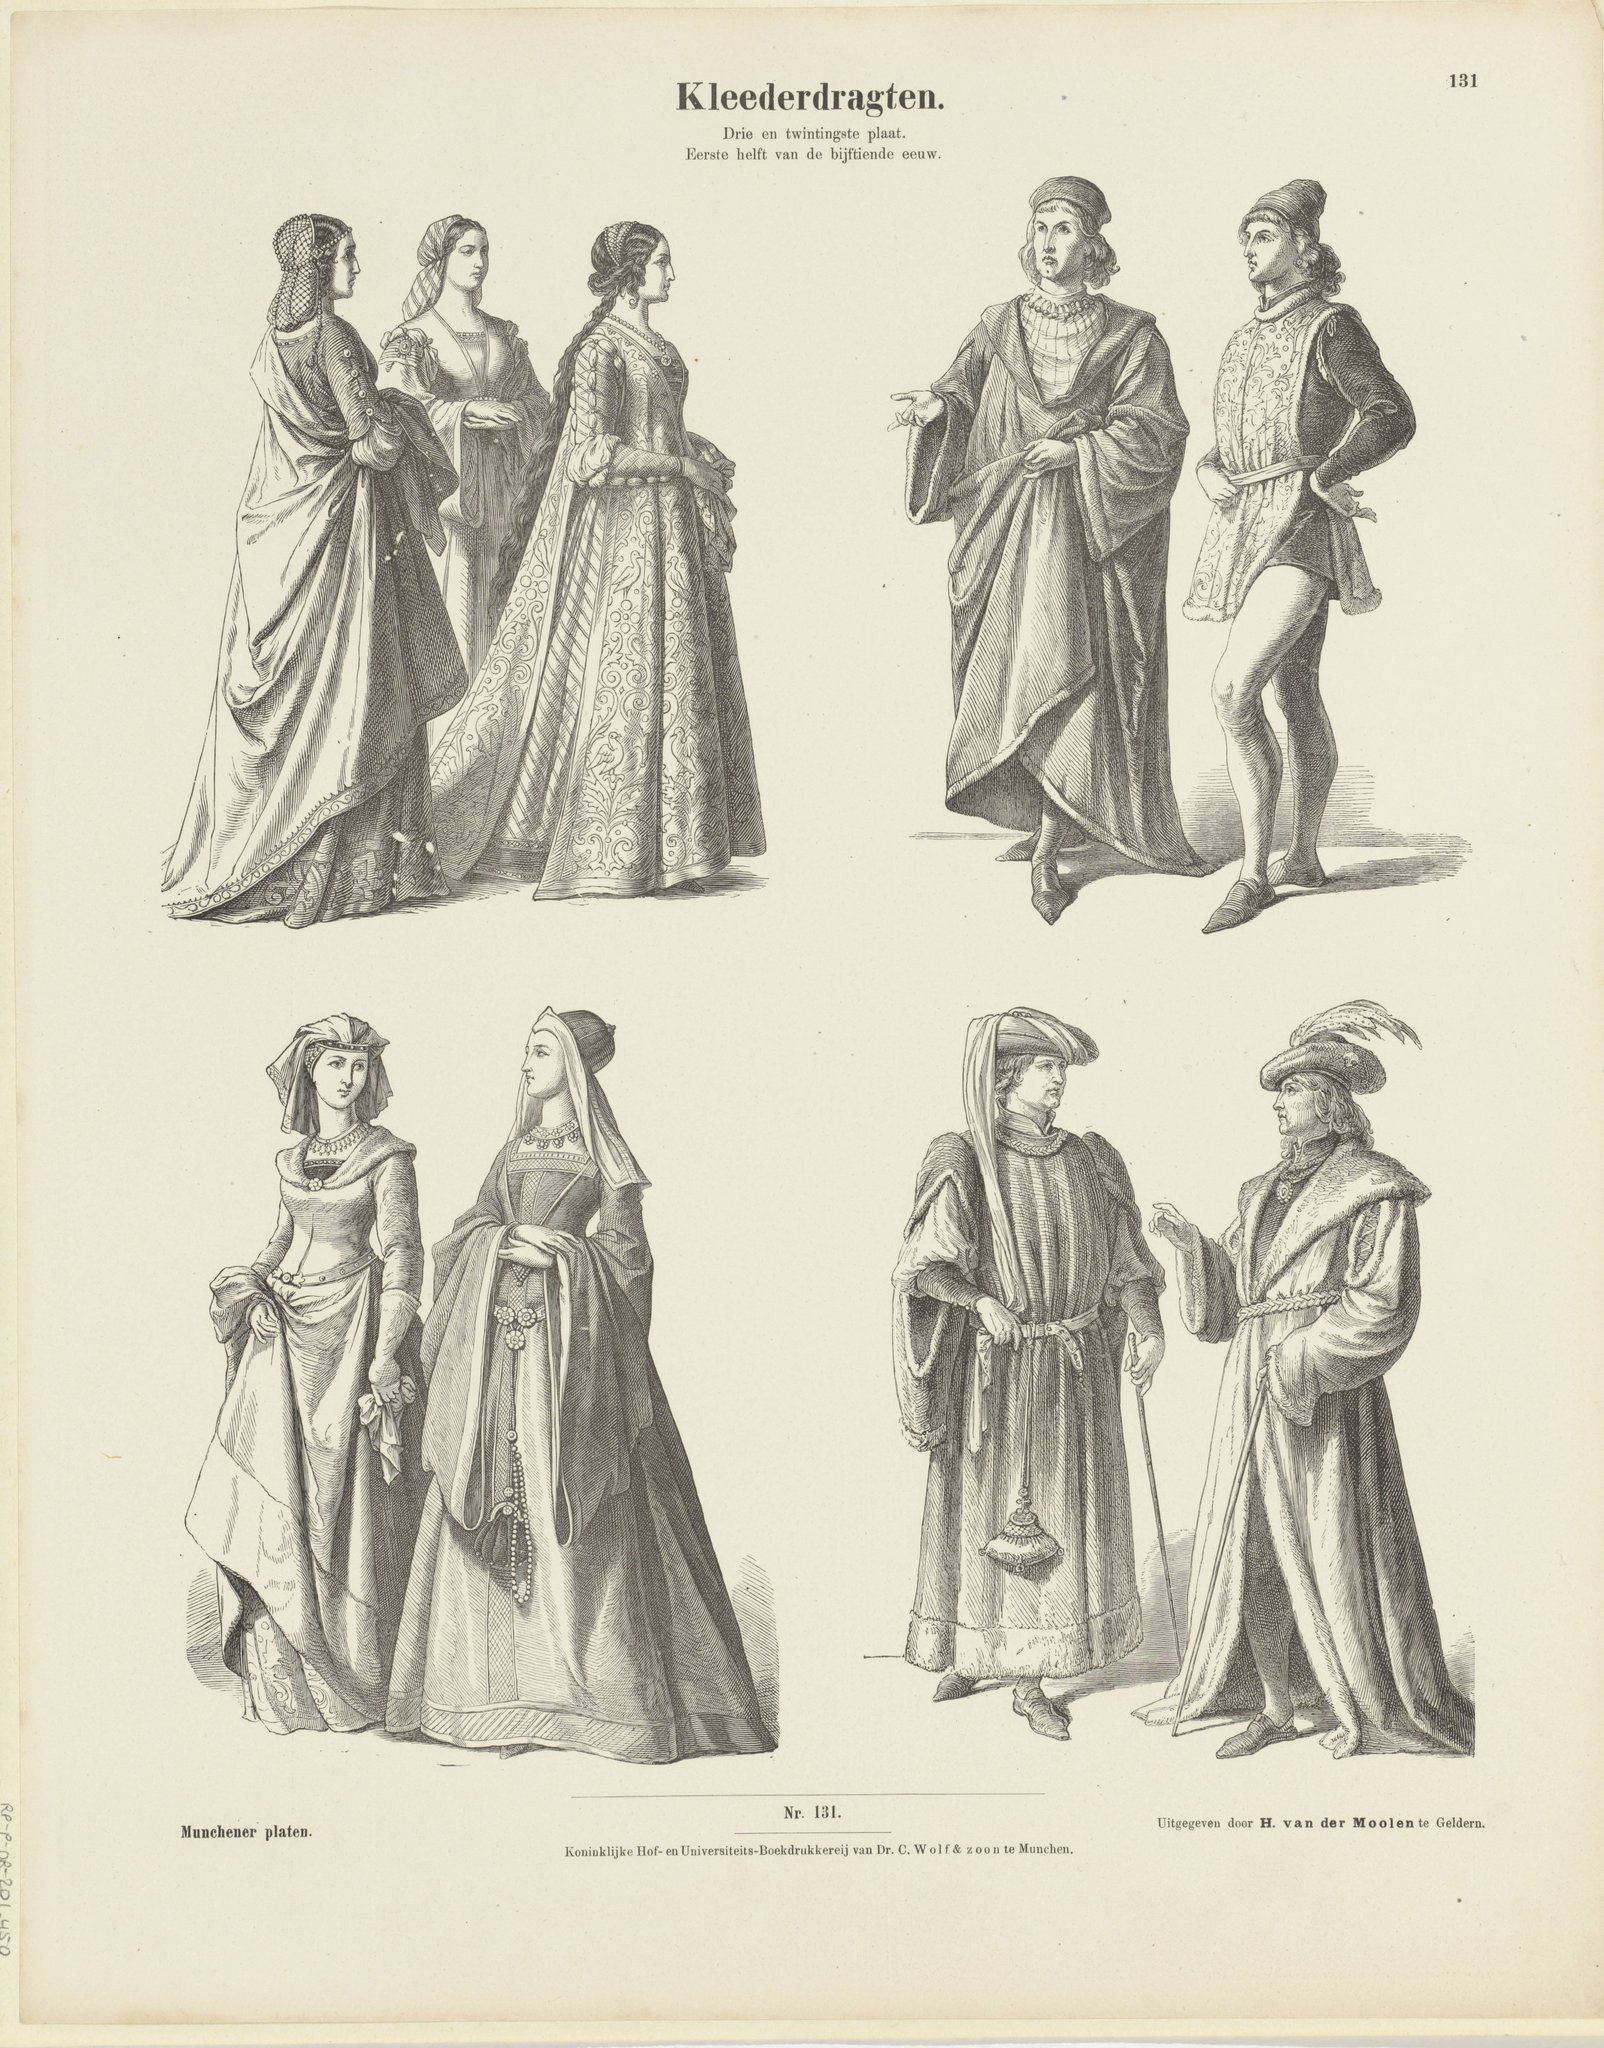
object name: print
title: Munchener platen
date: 1843-1920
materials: paper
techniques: letterpress printing, engraving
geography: germany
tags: historical costume, folk costume, regional costume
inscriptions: collector's mark: Lugt 2760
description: Nederlandse editie van een prent uit de reeks "Munchener platen" uitgegeven door K. Braun & Fr. Schneider te München met het adres van wederverkoper Hermann van der Moolen.